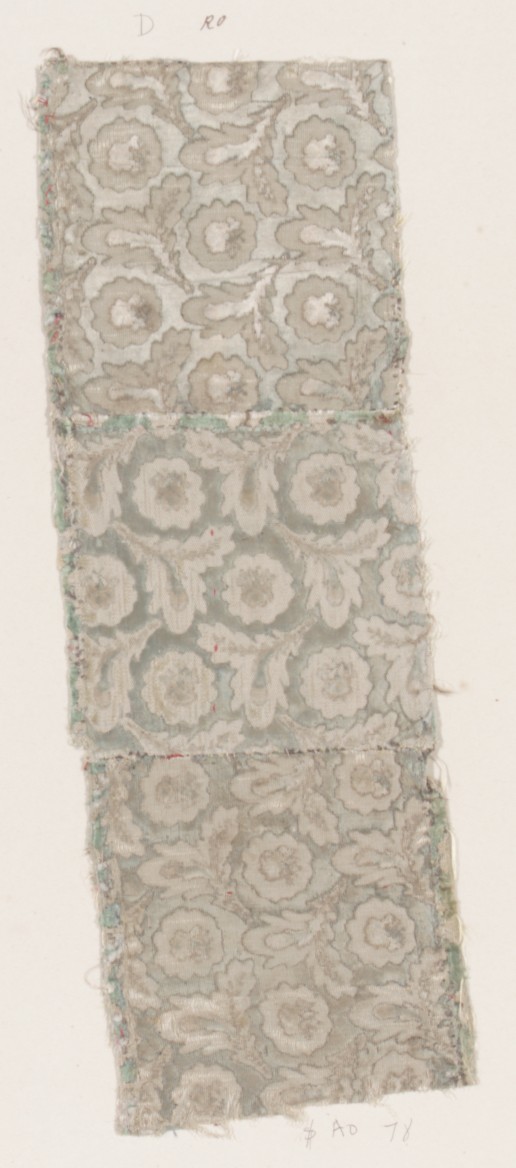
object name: fragment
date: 1701-1800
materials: silk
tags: flowers,leaves